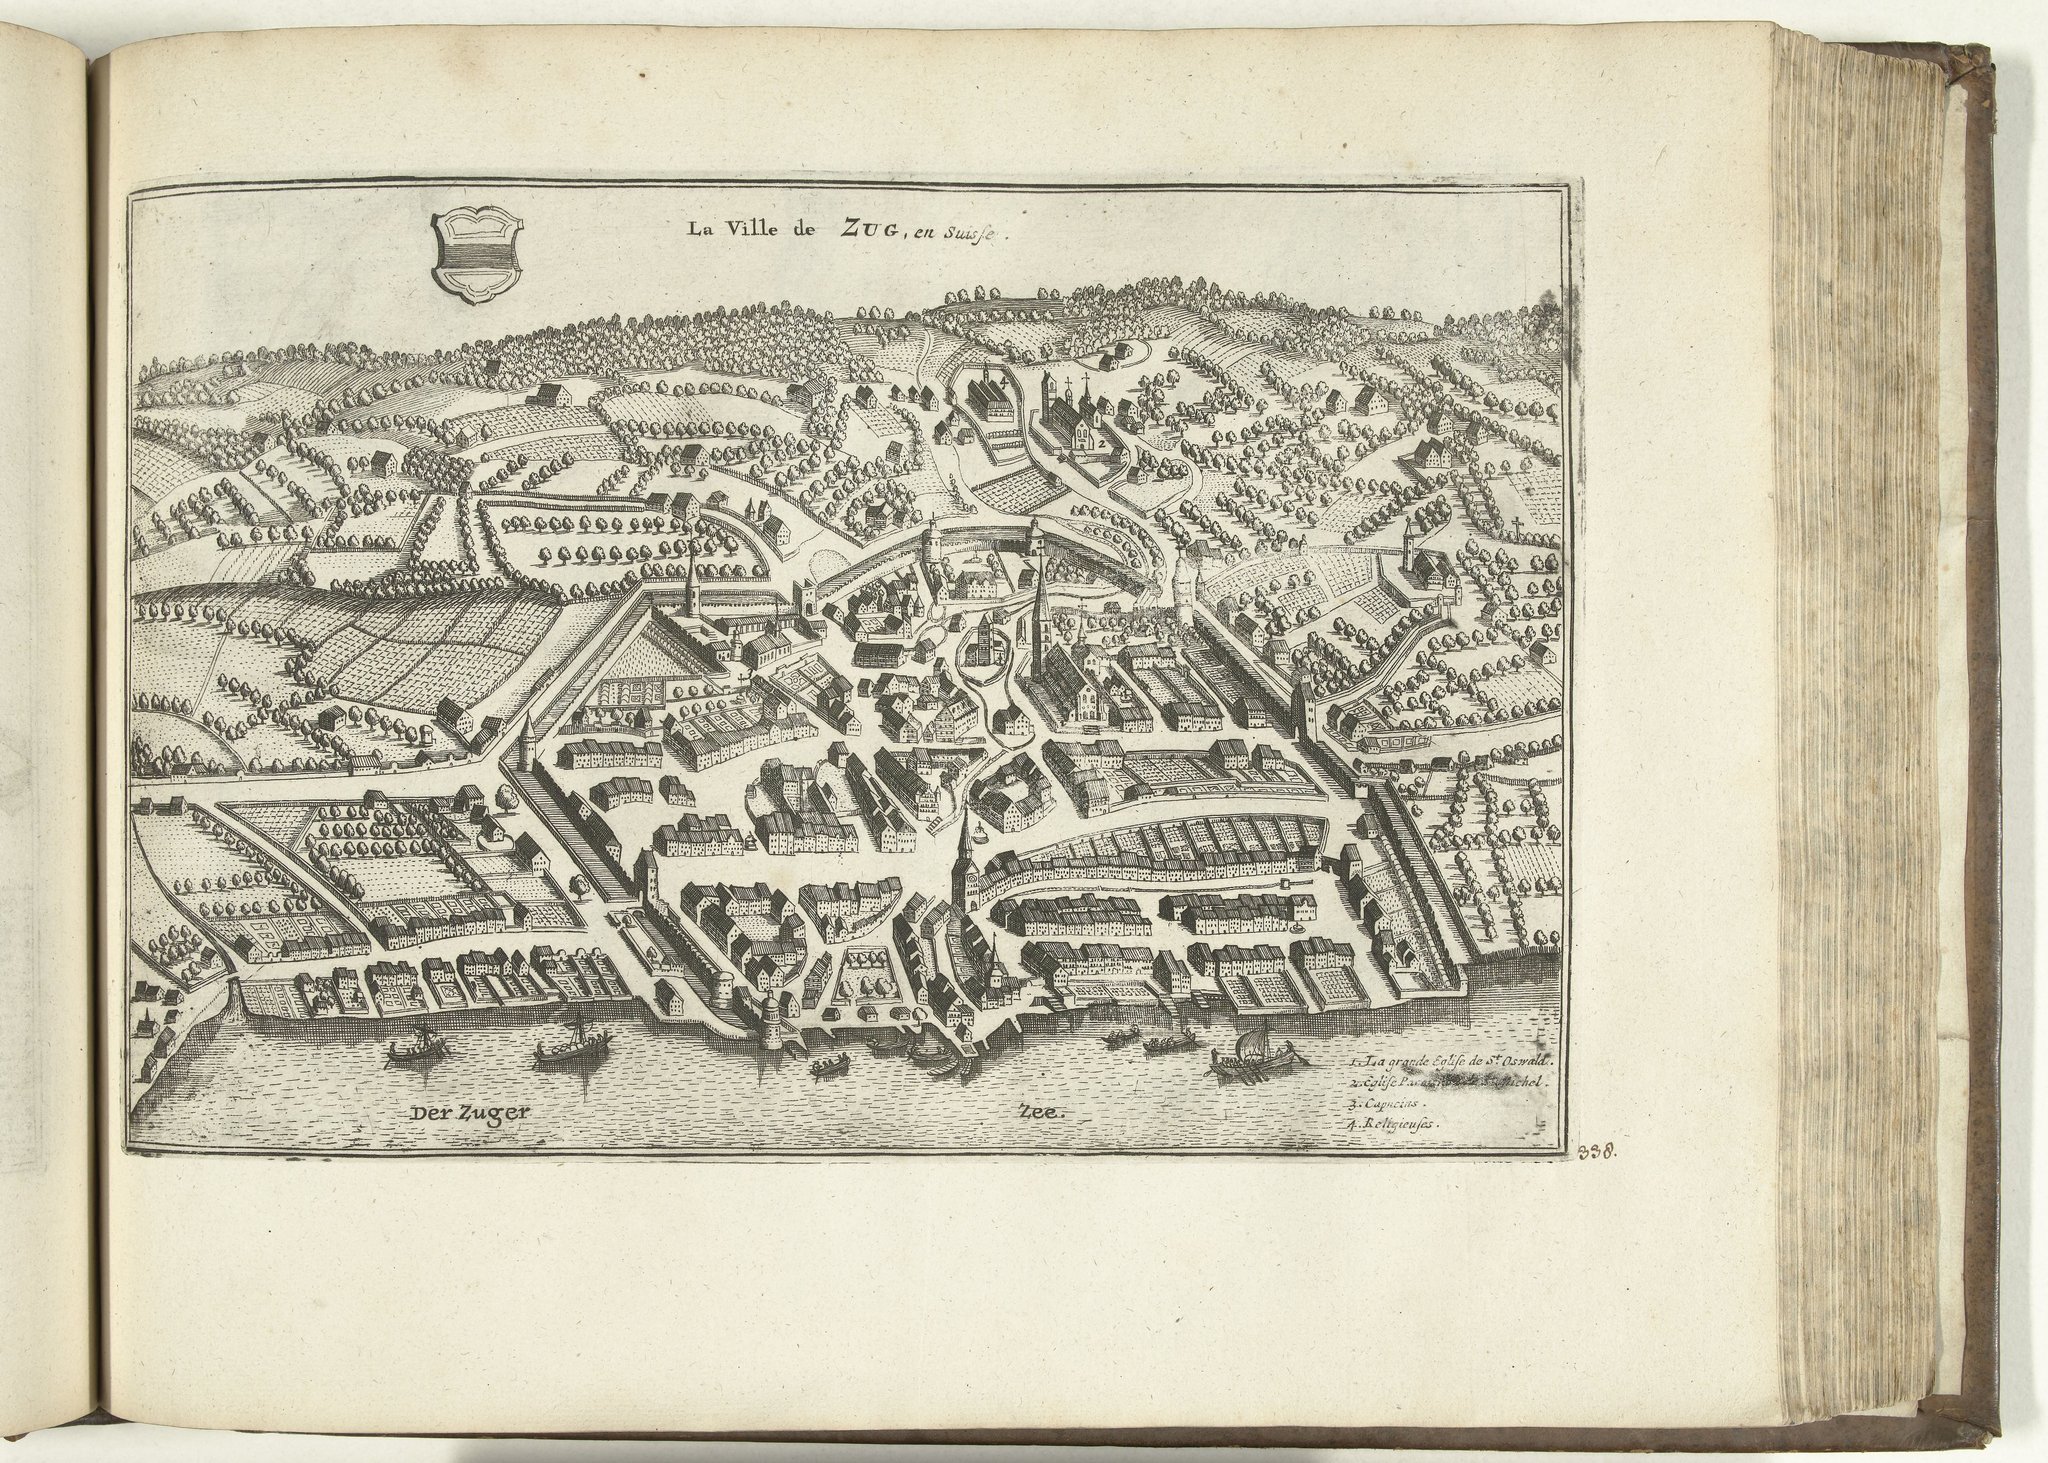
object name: print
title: La Ville de Zug, en Suisse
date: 1726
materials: paper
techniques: etching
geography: northern netherlands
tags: zug, spaanse successieoorlog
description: Gezicht op Zug in Zwitserland. Plaat nr. 338 in deel XIV van het prentwerk: Les Forces de l'Europe, Asie, Afrique et Amerique ... Comme aussi les Cartes des Côtes de France et d'Espagne uit 1726, dit tweede deel met 271 met de hand genummerde platen van vermaarde sterke steden en vestingen in het kader van de Spaanse Successieoorlog 1701-1713. Voor het merendeel zijn deze platen gekopieerd naar de anonieme Franse platen van vermaarde sterke steden en vestingen: in Les forces de l'Europe en in: Le theatre de la guerre, dans les Pays-Bas, beide oorspronkelijk uitgegeven door Nicolas de Fer te Parijs (1693-1697) in het kader van de Negenjarige Oorlog. Titel en opschriften in het Frans.